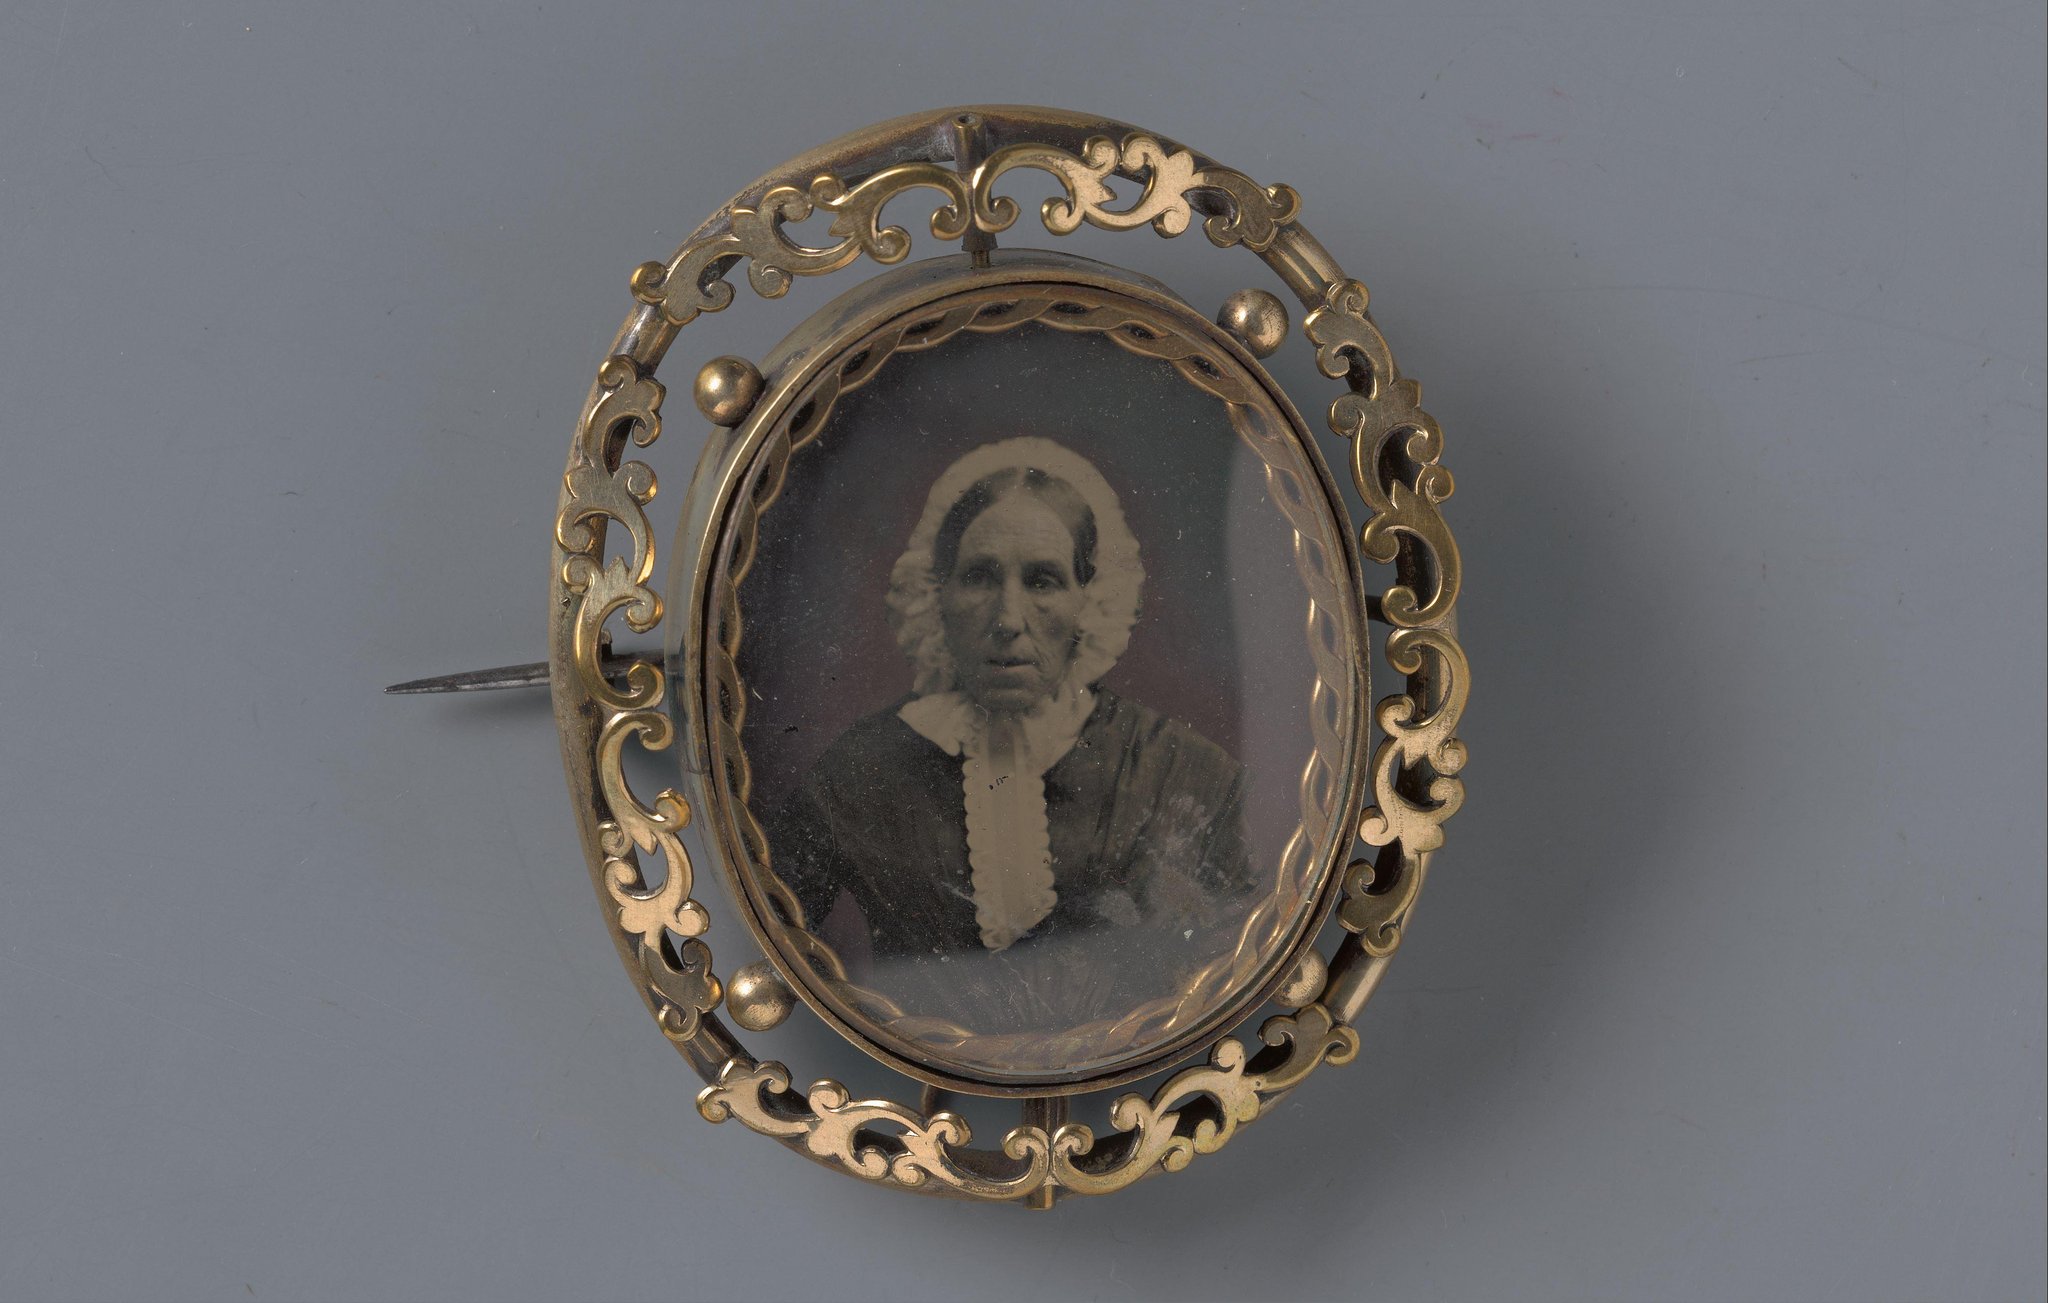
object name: photograph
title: Portret van een onbekende vrouw met kap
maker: Anonymous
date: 1855-1870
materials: glass, metal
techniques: ambrotype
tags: historical persons - bb - woman, head-gear: hat